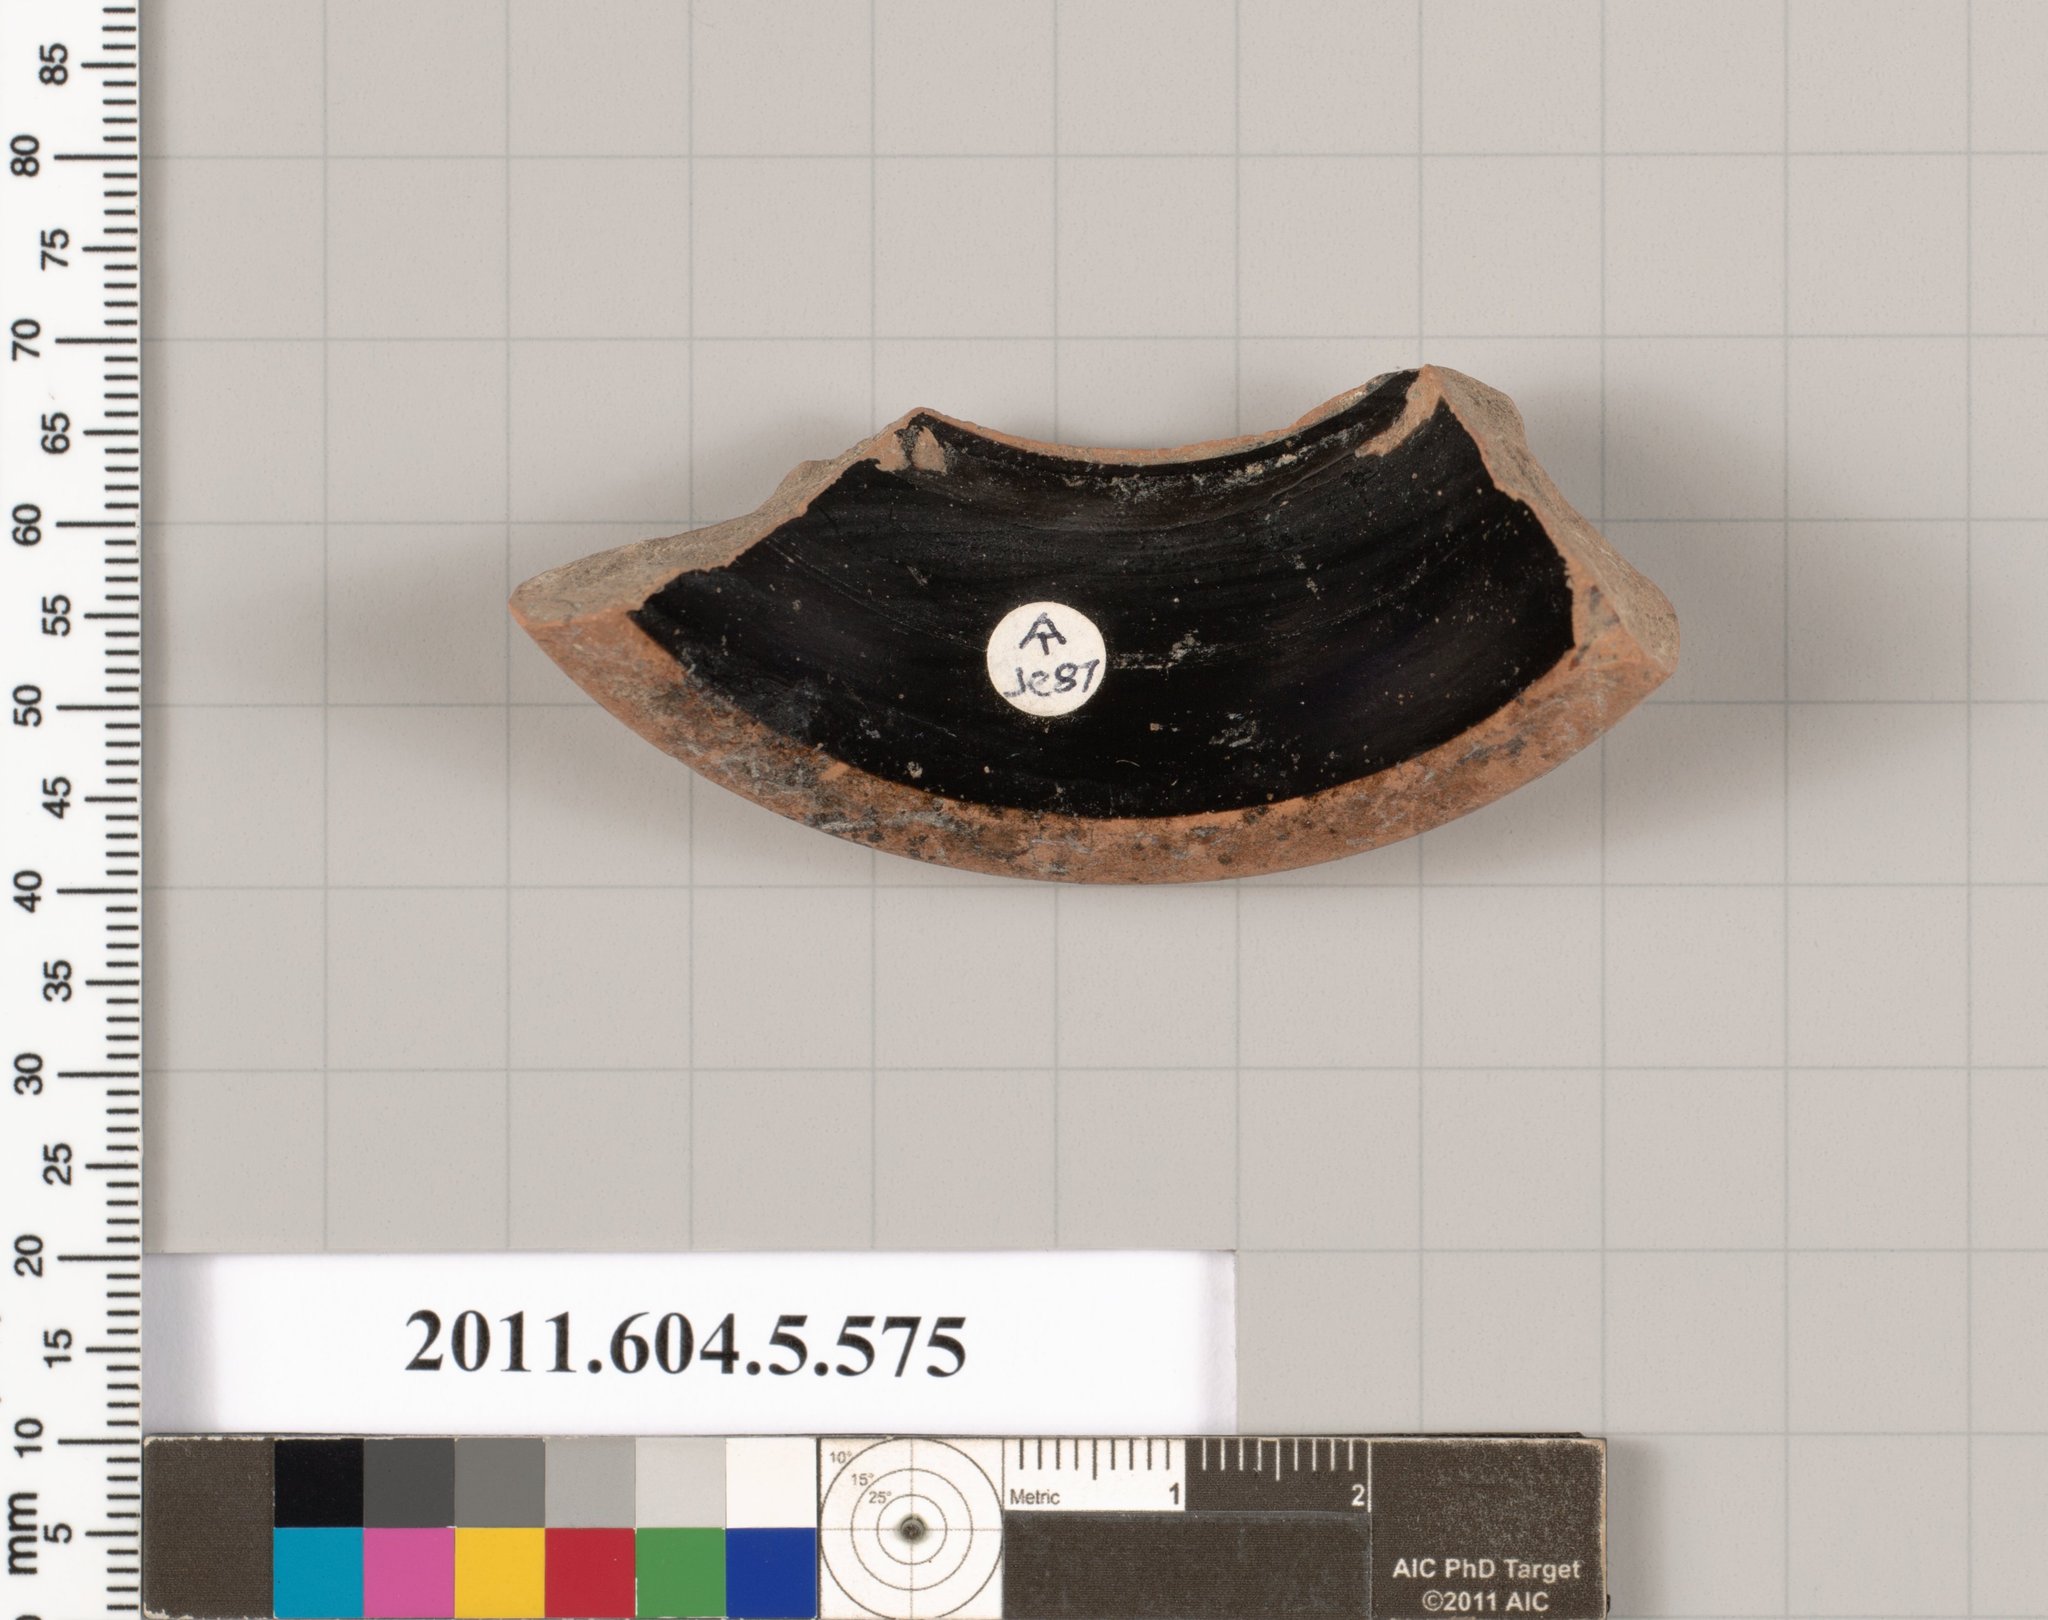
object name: stemless kylix fragment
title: Terracotta fragment of a stemless kylix (drinking cup)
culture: greek, attic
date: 600-401 BCE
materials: terracotta